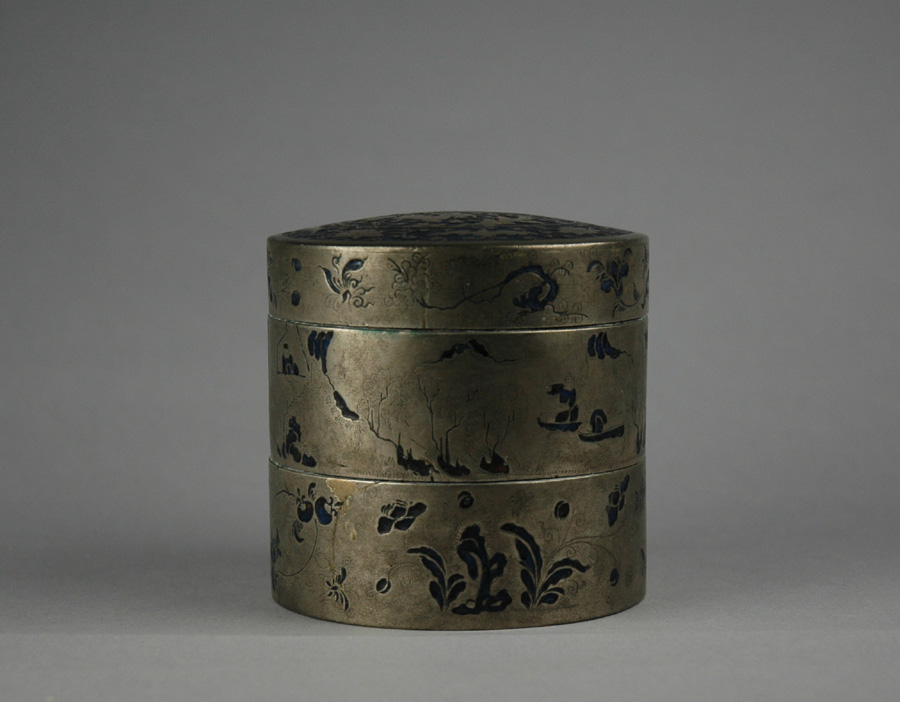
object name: tiered box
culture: chinese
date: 1801-1900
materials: enamel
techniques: painting